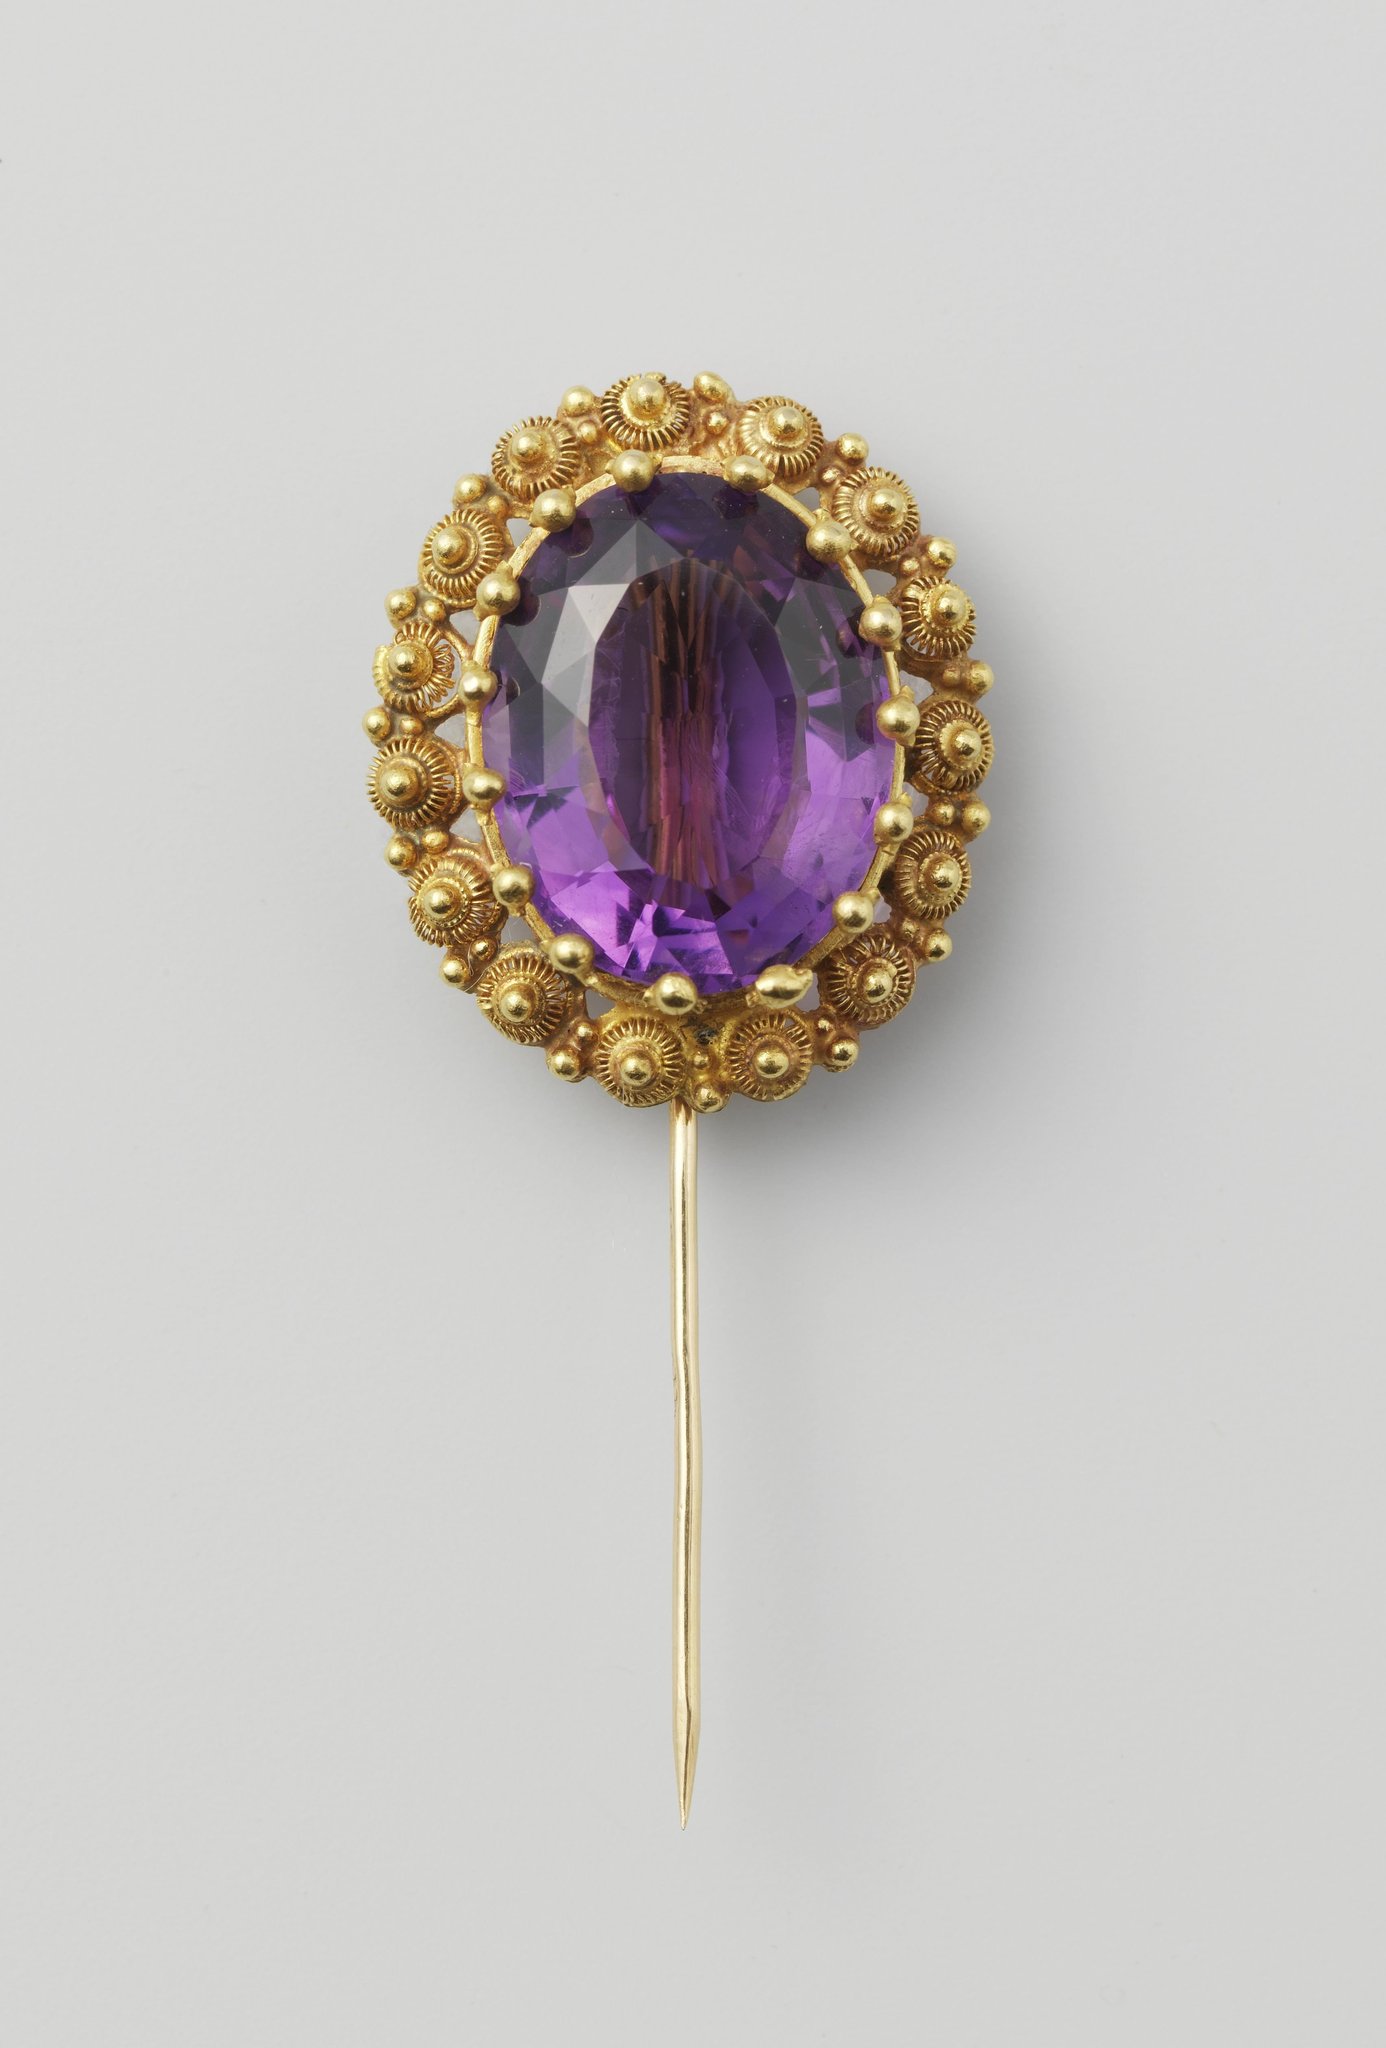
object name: jewellery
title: Speld van goud en amethist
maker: jean baptiste bonnard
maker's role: goldsmith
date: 1824-1829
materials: gemstone, gold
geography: amsterdam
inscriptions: alloy mark: ‘leeuwenkop naar links (Nederland, 1813-1906)’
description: Parure. Gold and amethyst. Amsterdam, c. 1824 - 1829, by Jean Baptiste Bonnard.